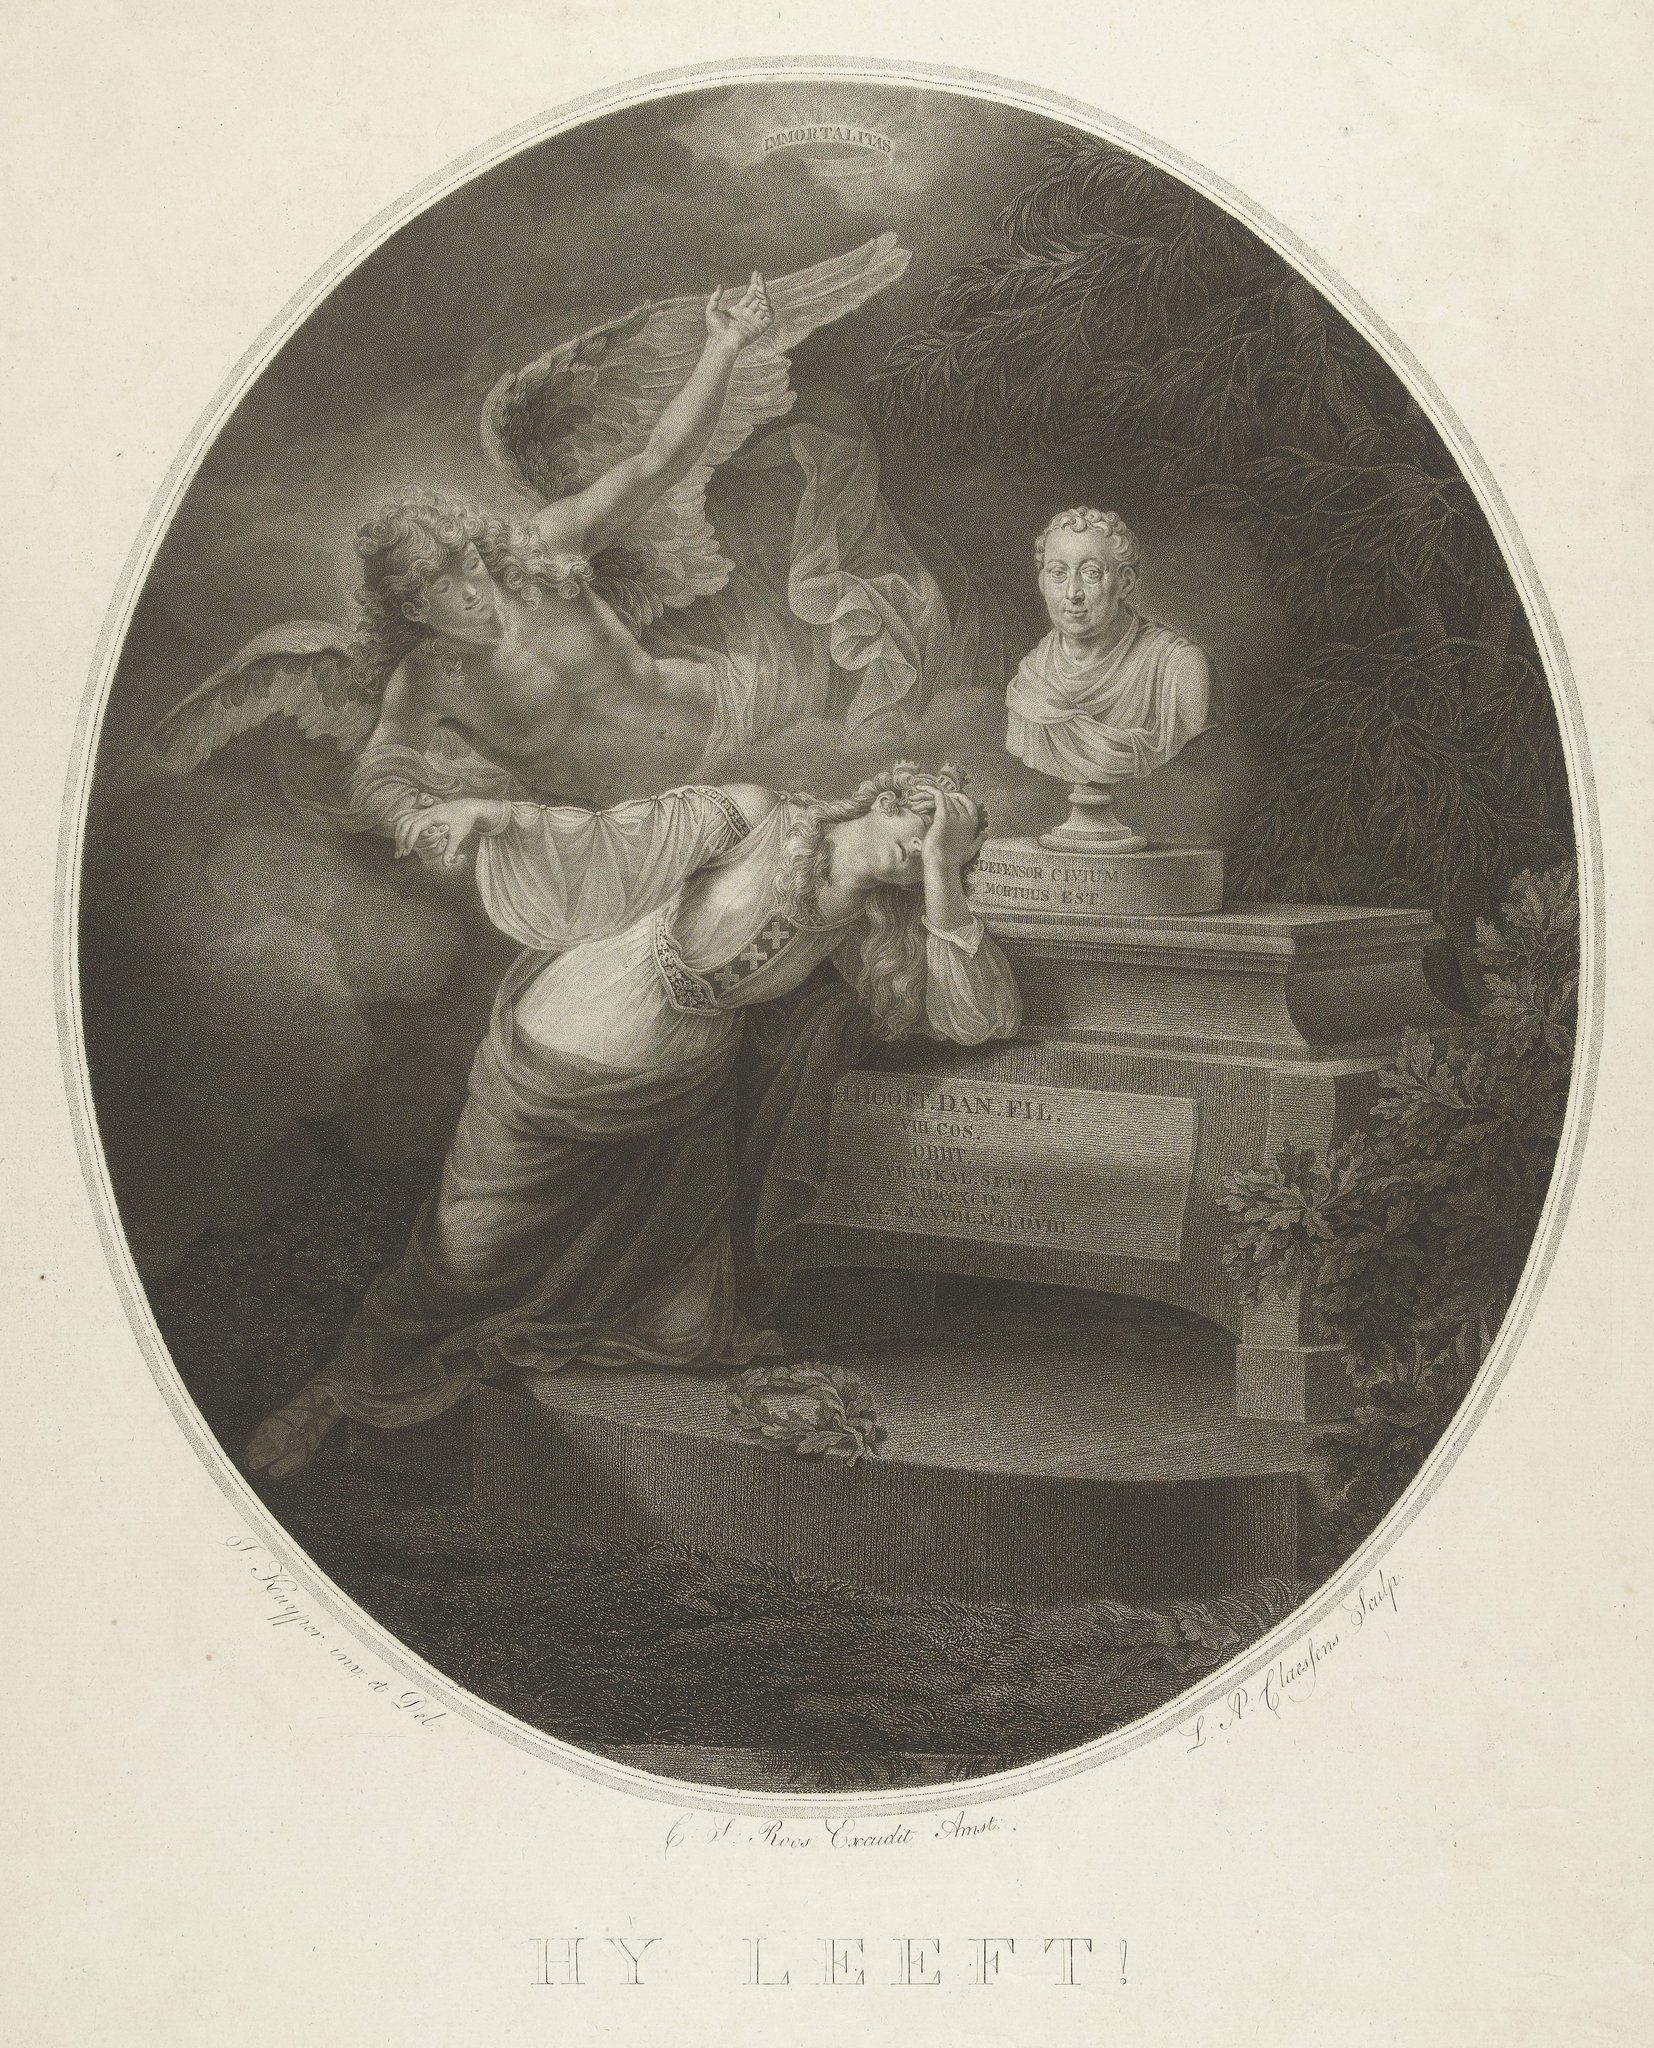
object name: print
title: Memorieprent voor Hendrik Hooft Daniëlsz.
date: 1794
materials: paper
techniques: etching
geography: amsterdam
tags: amsterdam, mayor, hendrik danielsz. hooft, personification of a city, town-patron(ess), grave, tomb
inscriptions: collector's mark: Lugt 2228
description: De Amsterdamse stedenmaagd rouwt bij het graf van de Amsterdamse burgermeester Hendrik Hooft Daniëlsz. Een engel steunt haar in het verdriet en wijst haar op de onsterfelijkheid van de overledene. Op de graftombe staat een portretbuste van Hooft Daniëlsz. in antieke stijl.